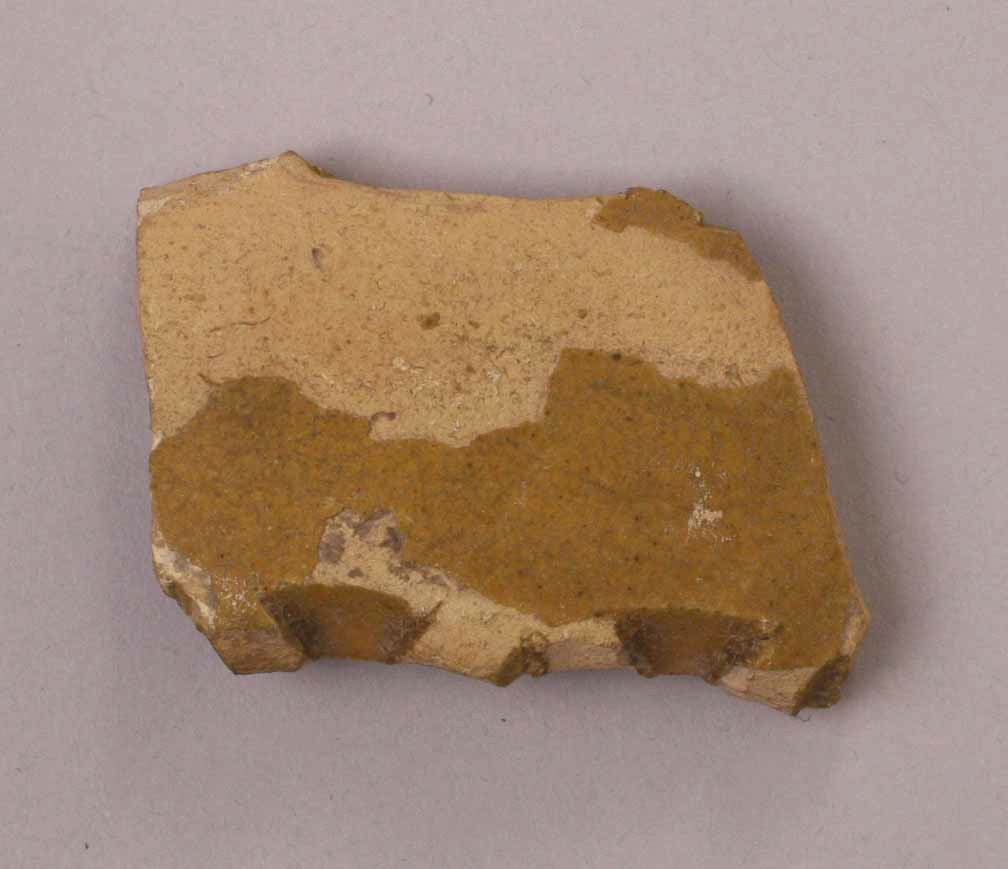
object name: fragment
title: Ceramic Fragments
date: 801-900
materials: earthenware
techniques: glazing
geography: iraq